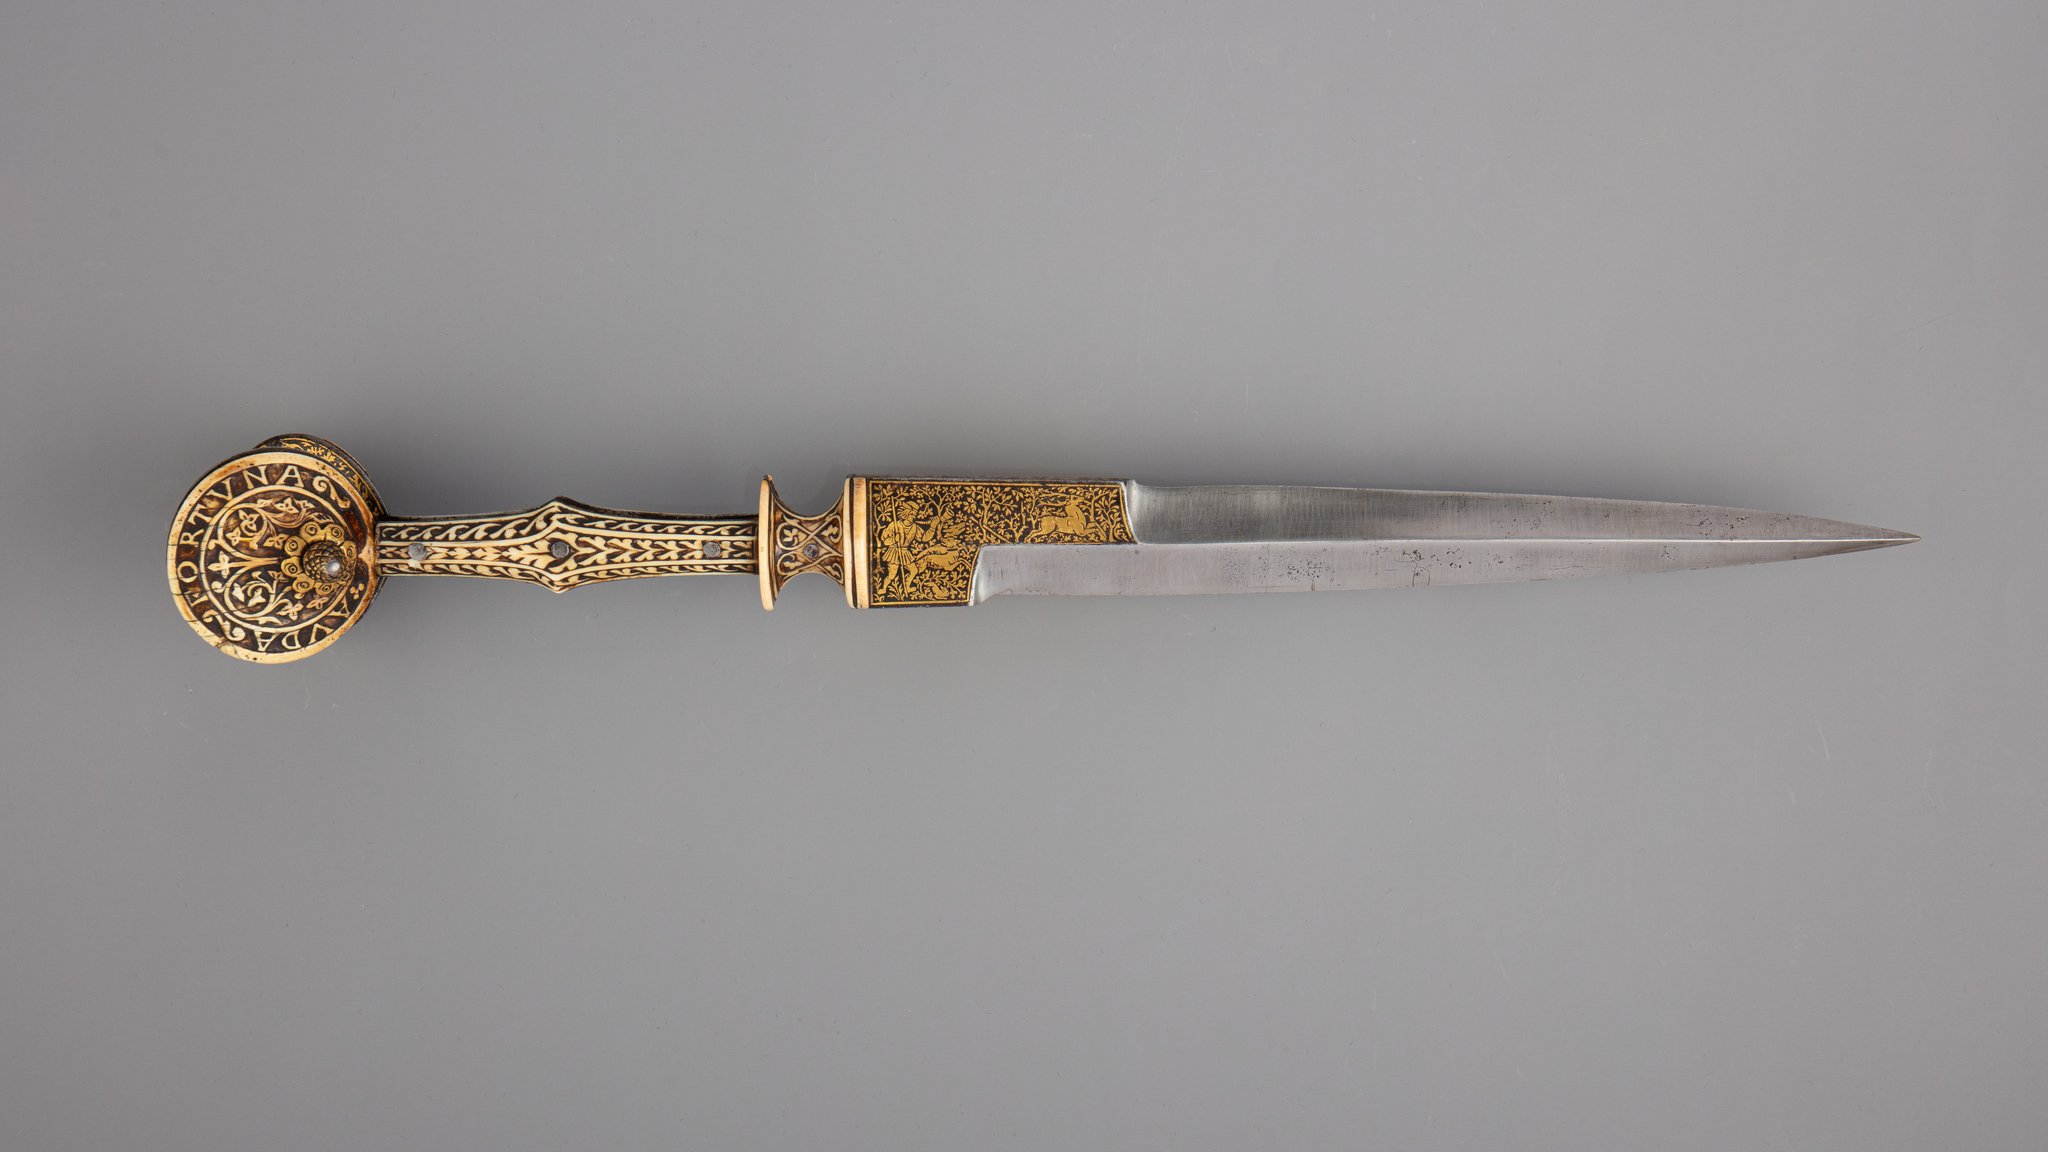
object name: eared dagger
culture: spanish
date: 1540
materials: gold, ivory, steel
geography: spain